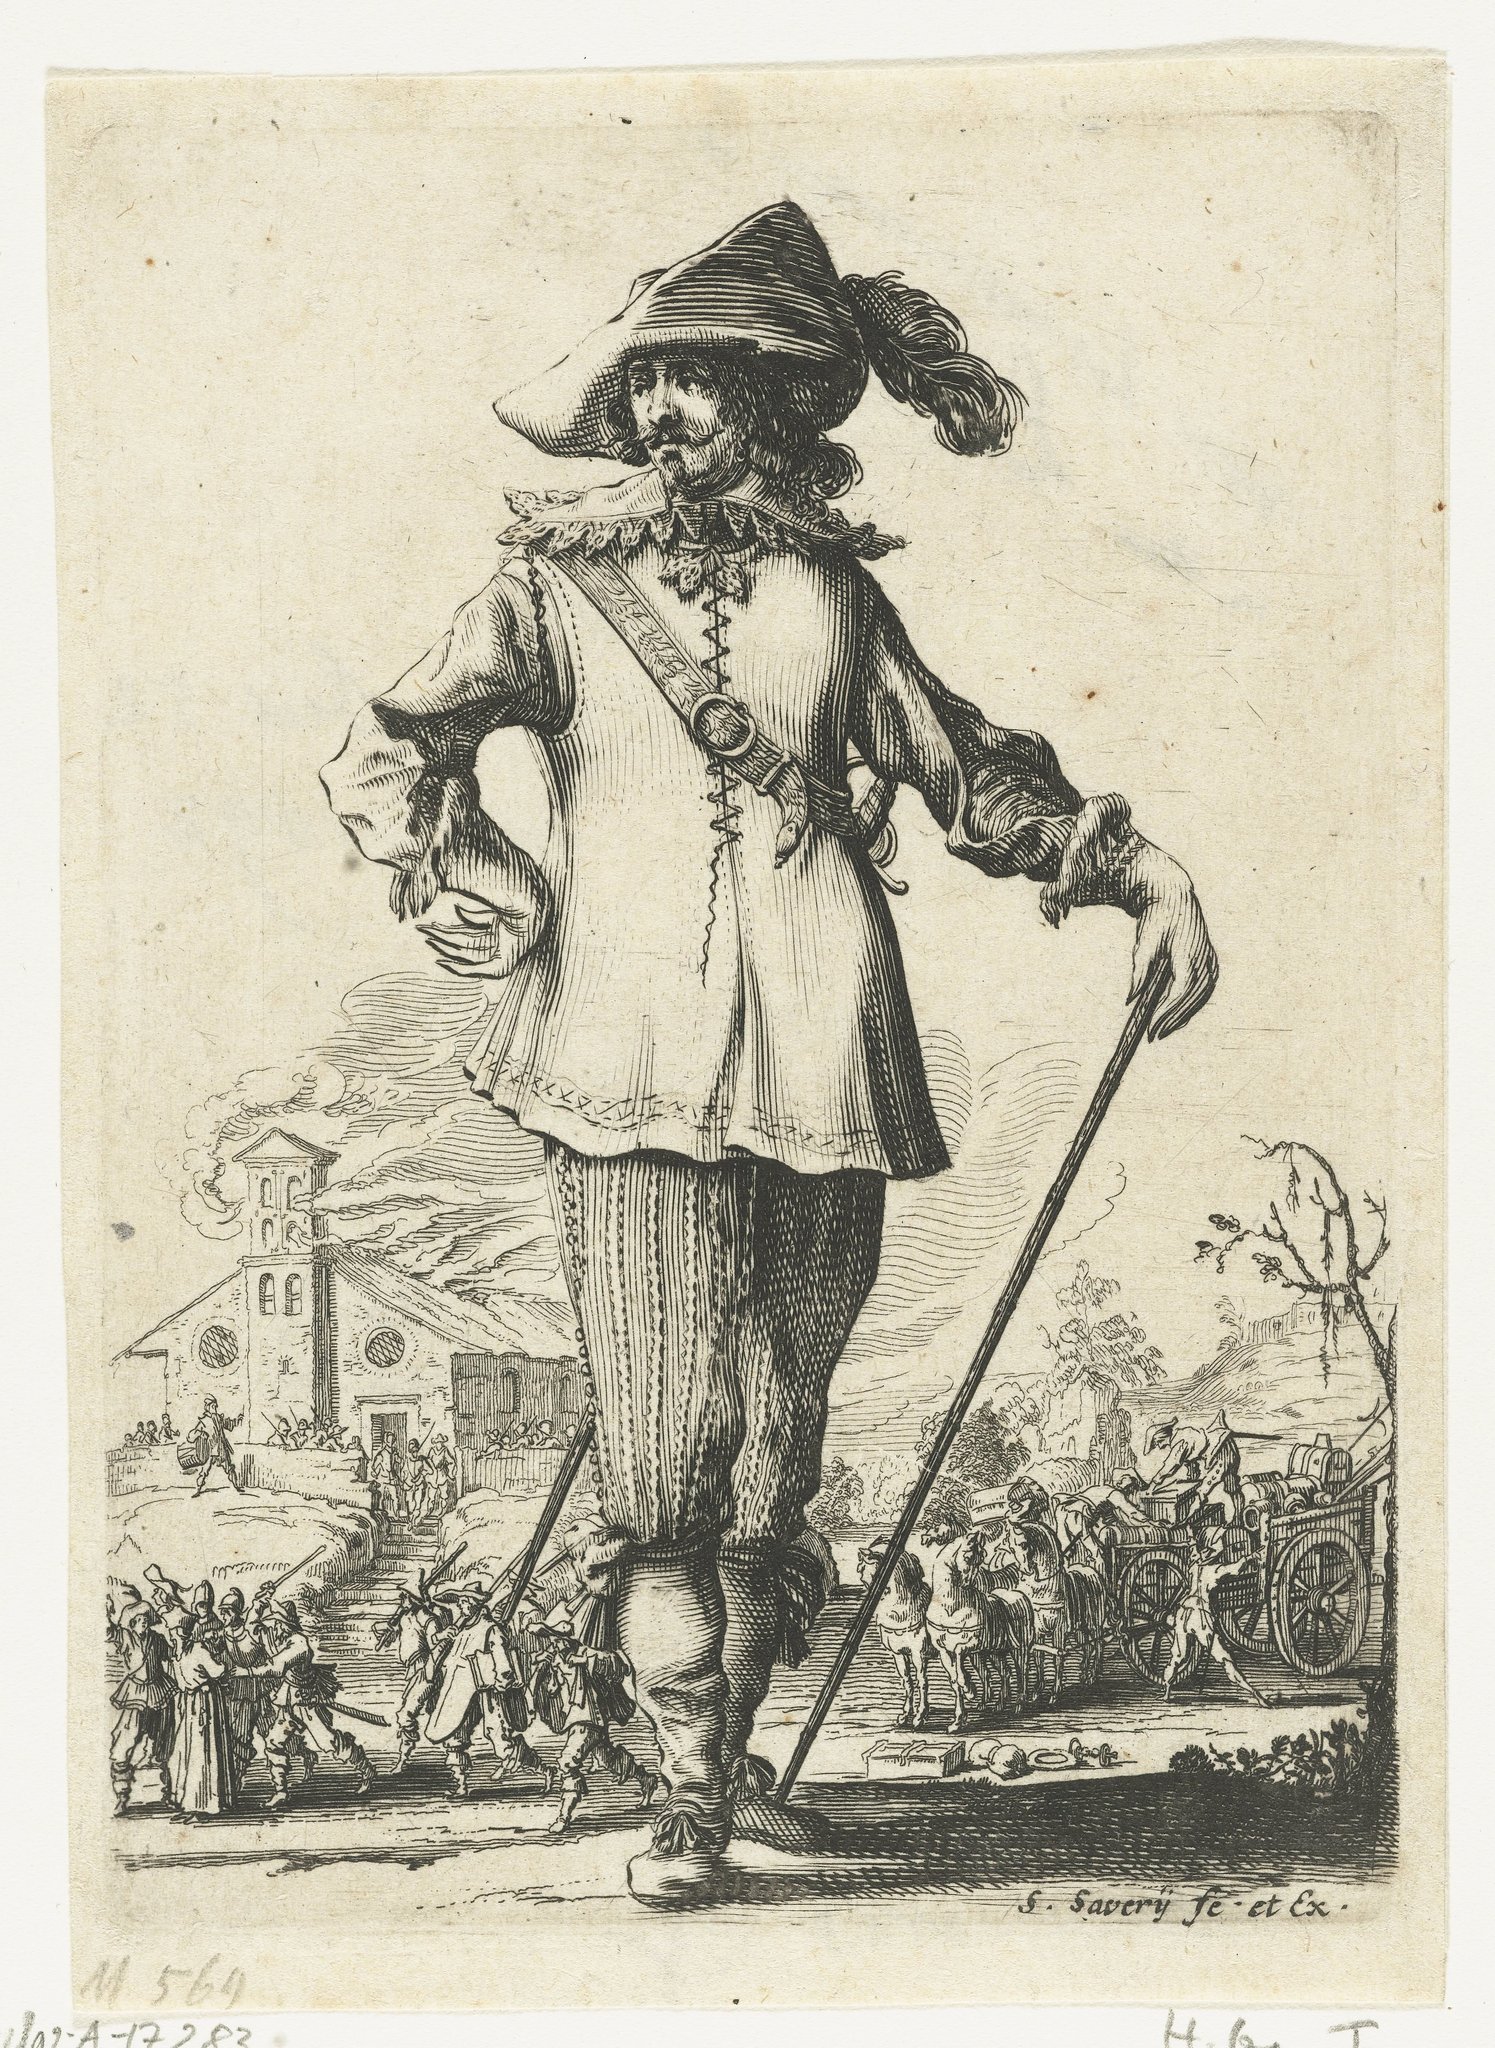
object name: costume print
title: Staande officier met wandelstok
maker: salomon savery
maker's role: print maker, publisher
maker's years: 1594-1683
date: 1630-1665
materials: paper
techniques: engraving, etching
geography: amsterdam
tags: walking-stick, staff, clothes, costume (+ men's clothes), officer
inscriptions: collector's mark: Lugt 2228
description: Officier, van voren gezien, met in zijn linkerhand een wandelstok. Op de achtergrond een brandende kerk en figuren. De prent maakt deel uit van een tiendelige serie met voorstellingen van gewapende officieren en soldaten, gekleed volgens de Nederlandse mode ca. 1625-1635.